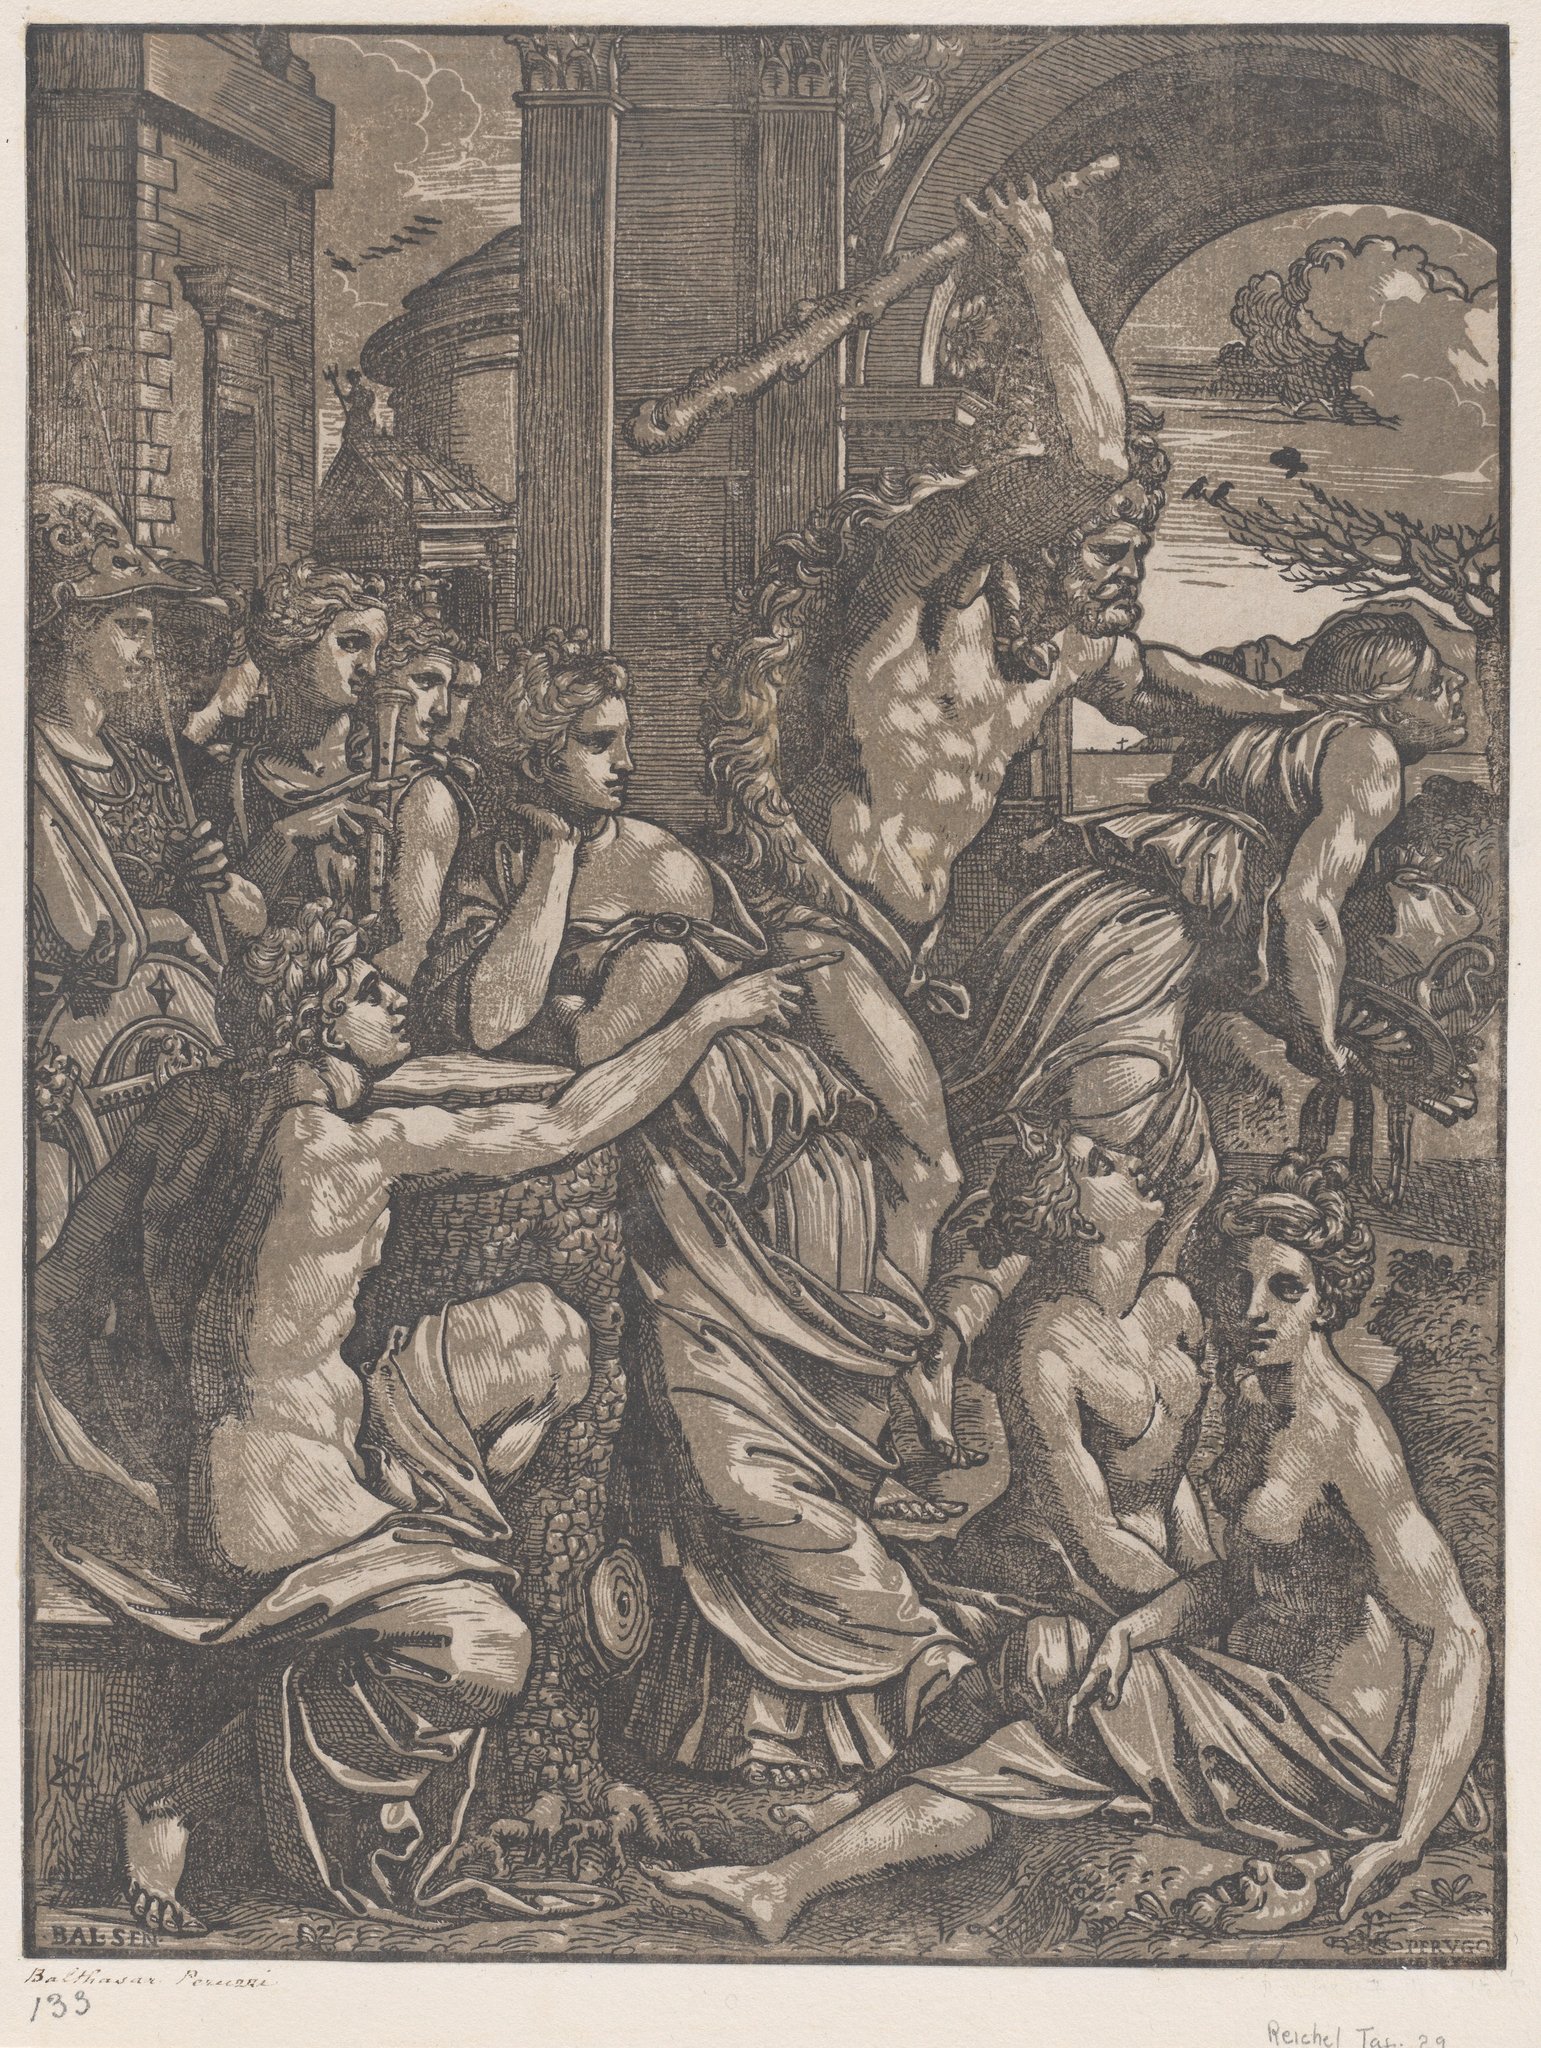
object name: print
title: Hercules chasing Avarice from the temple of the Muses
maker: ugo da carpi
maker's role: artist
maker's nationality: italian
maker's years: 1480-1532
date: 1520-1527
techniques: woodcut